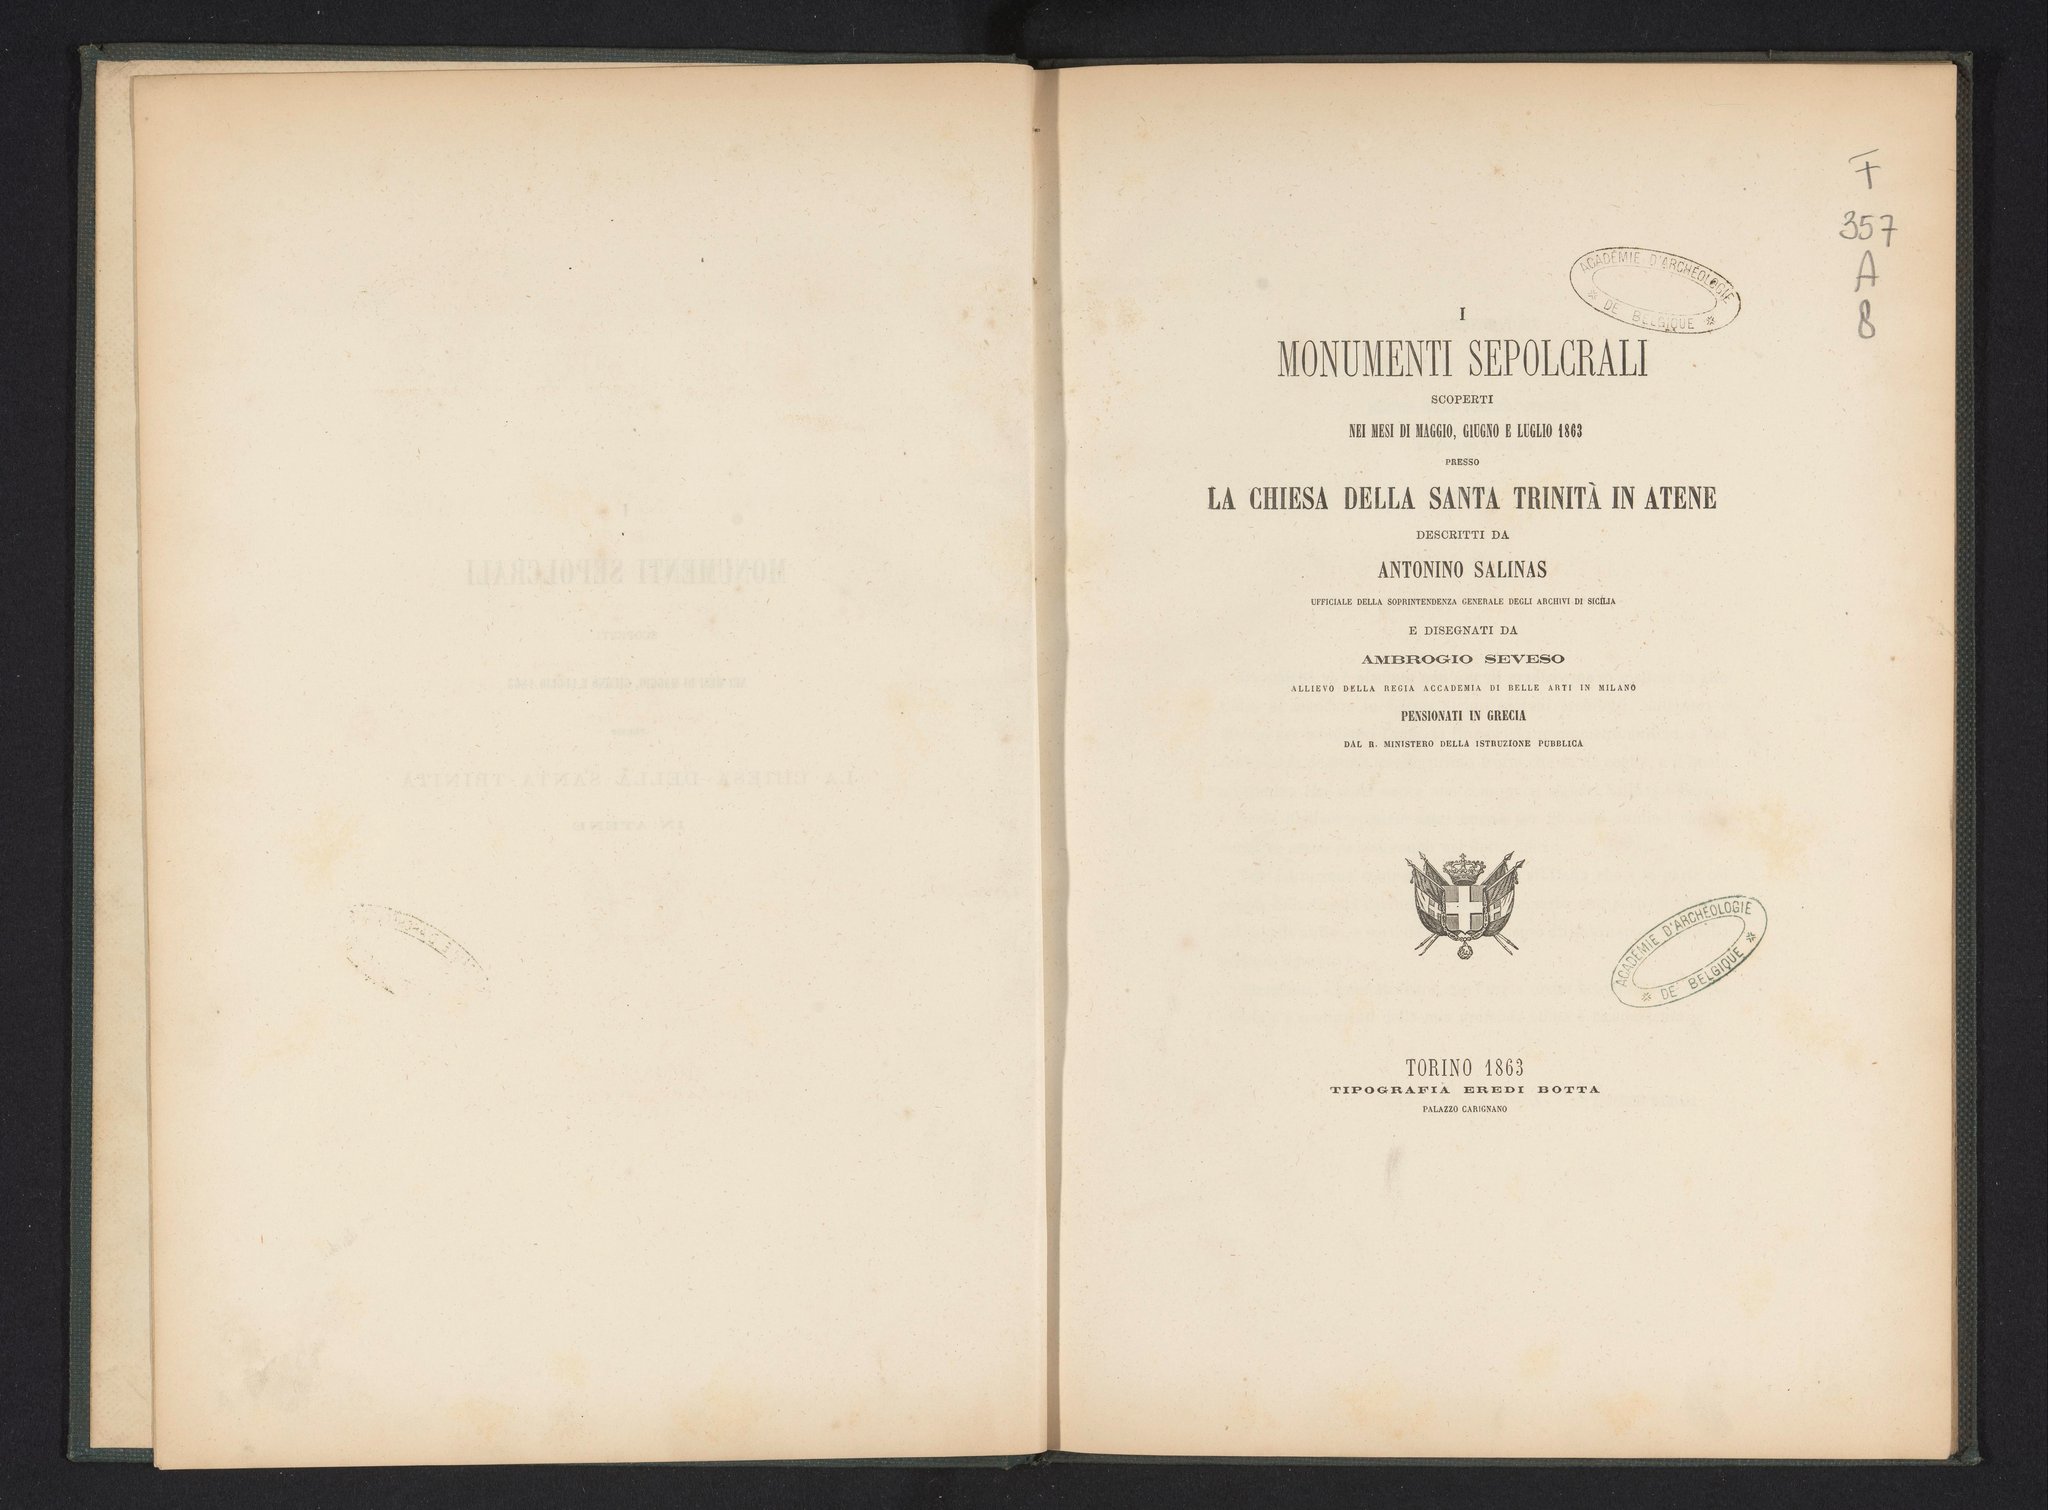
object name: book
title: I monumenti sepolcrali scoperti nei mesi di maggio, giugno e luglio 1863 presso la Chiesa della Santa Trinità in Atene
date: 1863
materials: cardboard, linen, paper, photographic support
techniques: albumen print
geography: turin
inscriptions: bookplate: ‘ex libris SFJ’, number: ‘in 40 86’, inscription: ‘Al Congresso internazionale archeologico in Anver[...] omaggio dell'ti A. [...]’